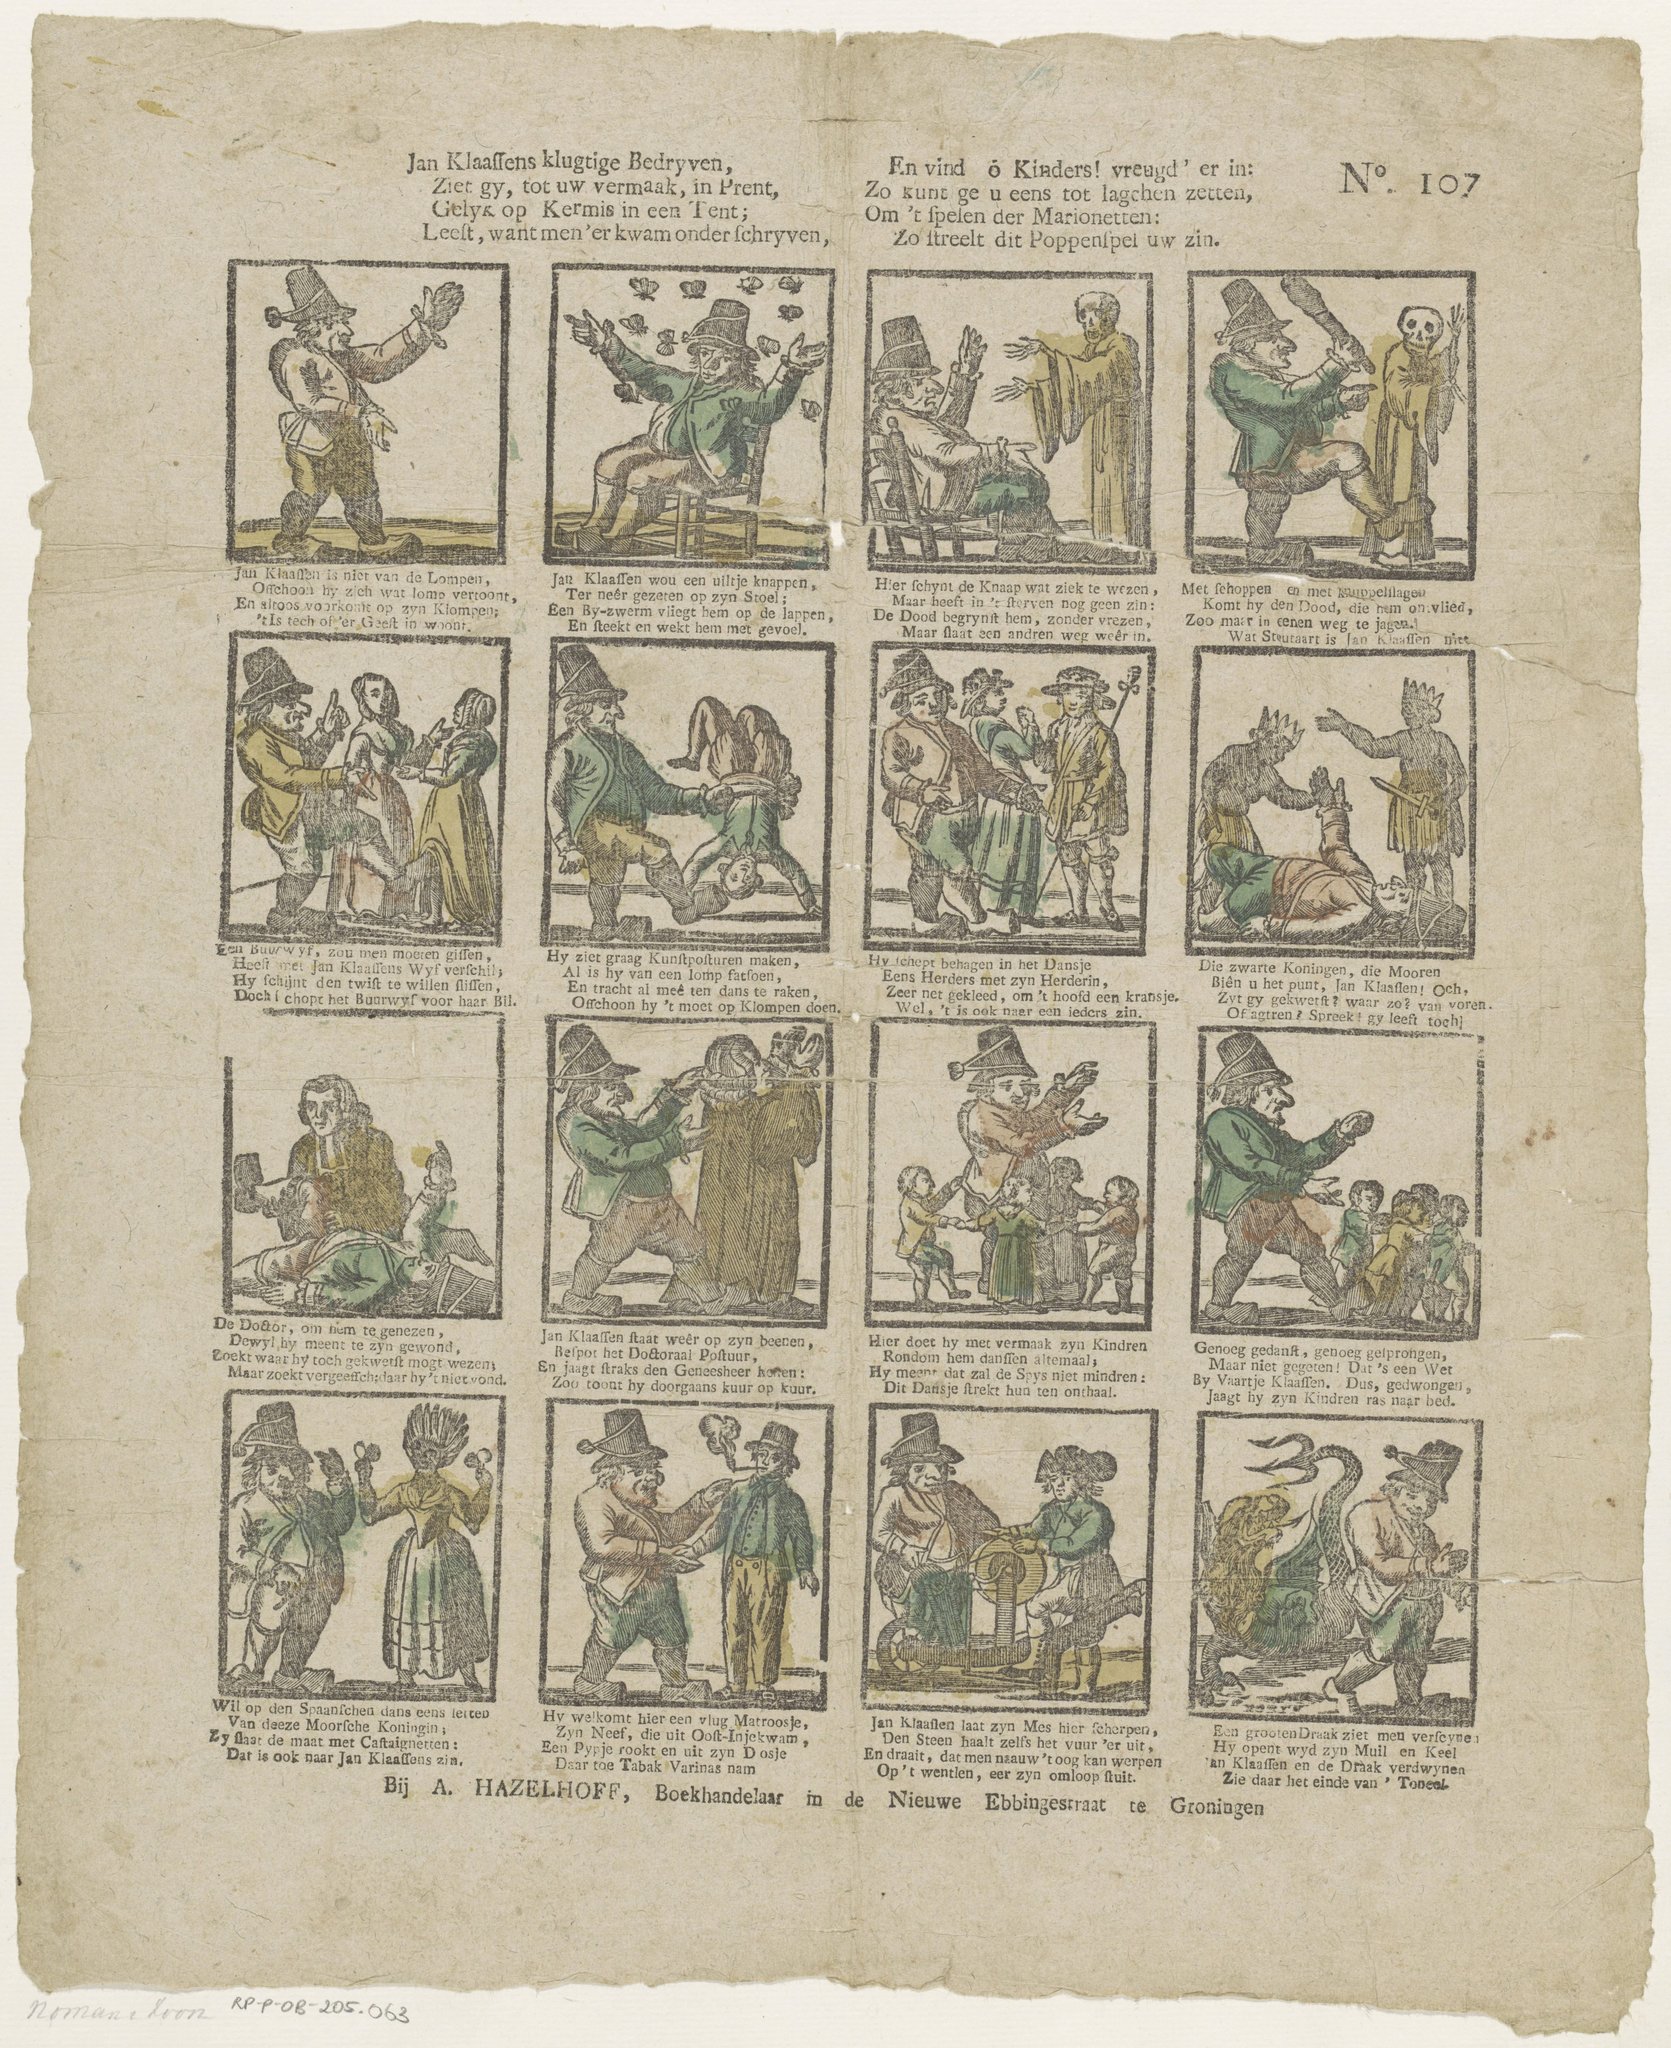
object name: popular print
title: Jan klaassens klugtige bedryven, / Ziet gy, tot uw vermaak, in prent [(...)]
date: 1806-1830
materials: paper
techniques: colour, letterpress printing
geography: zaltbommel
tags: punch and judy, tales and fairy tales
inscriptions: collector's mark: Lugt 2760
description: Blad met 16 voorstellingen over het leven van Jan Klaassen. Onder elke afbeelding een vierregelig vers. Genummerd rechtsboven: No. 107.